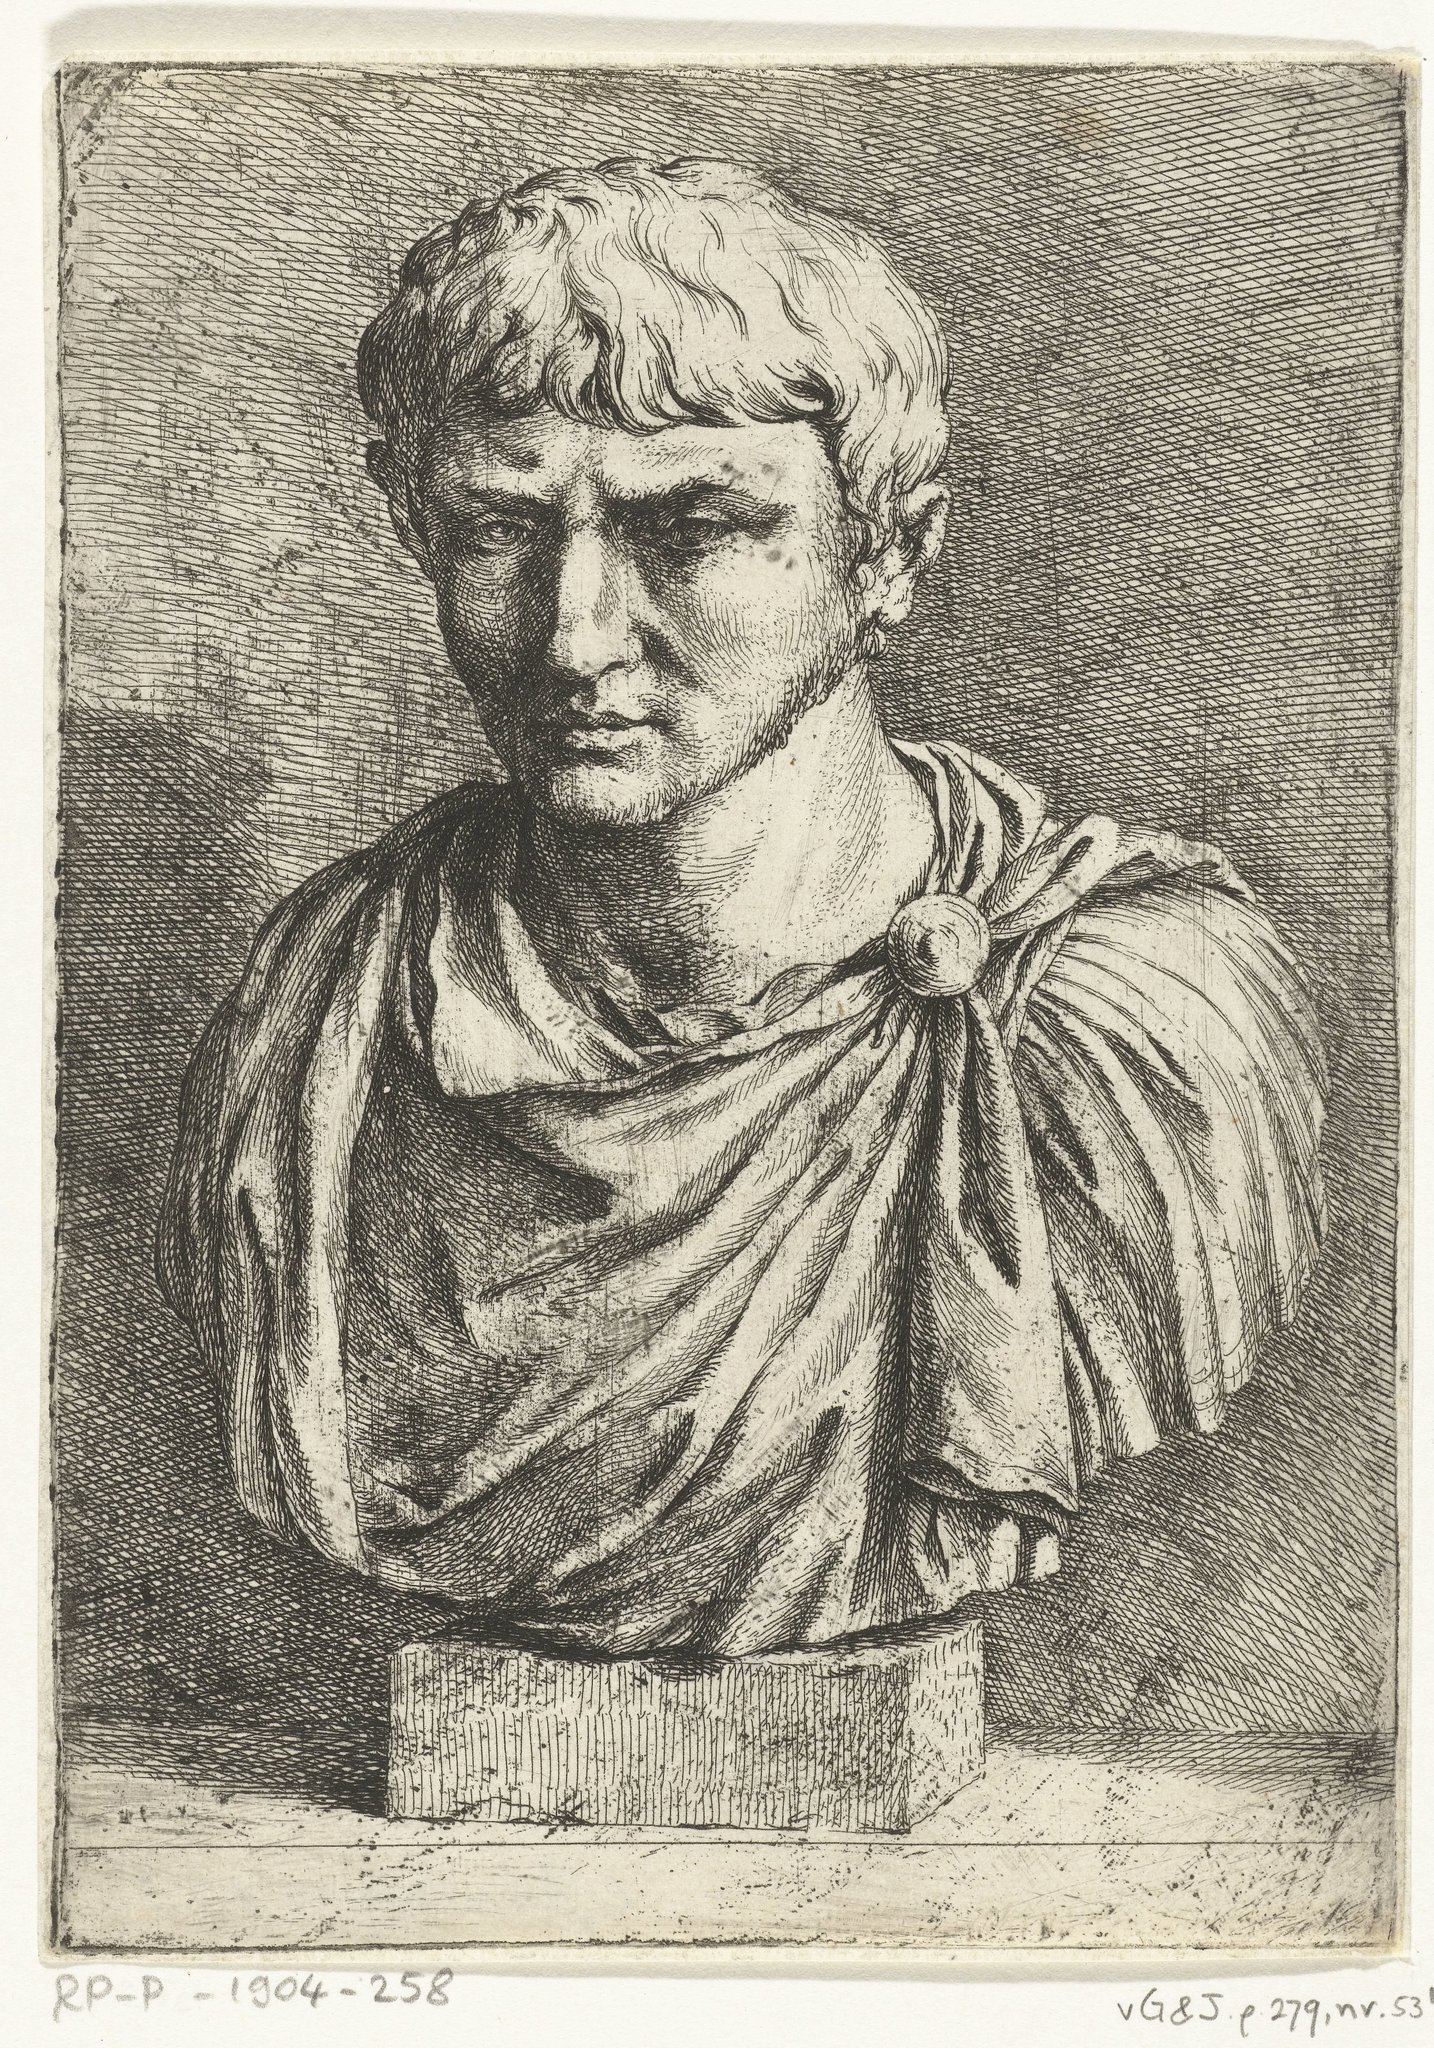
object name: print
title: Portretbuste van Pompeius of Augustus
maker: jan de bisschop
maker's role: draughtsman, print maker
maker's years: 1628-1671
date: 1666-1671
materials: paper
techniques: etching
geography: northern netherlands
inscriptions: collector's mark: Lugt 2228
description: afkomstig uit: Paradigmata graphices variorum artificum : voor-beelden der teken-konst van verscheyde meesters, (2e of latere editie)